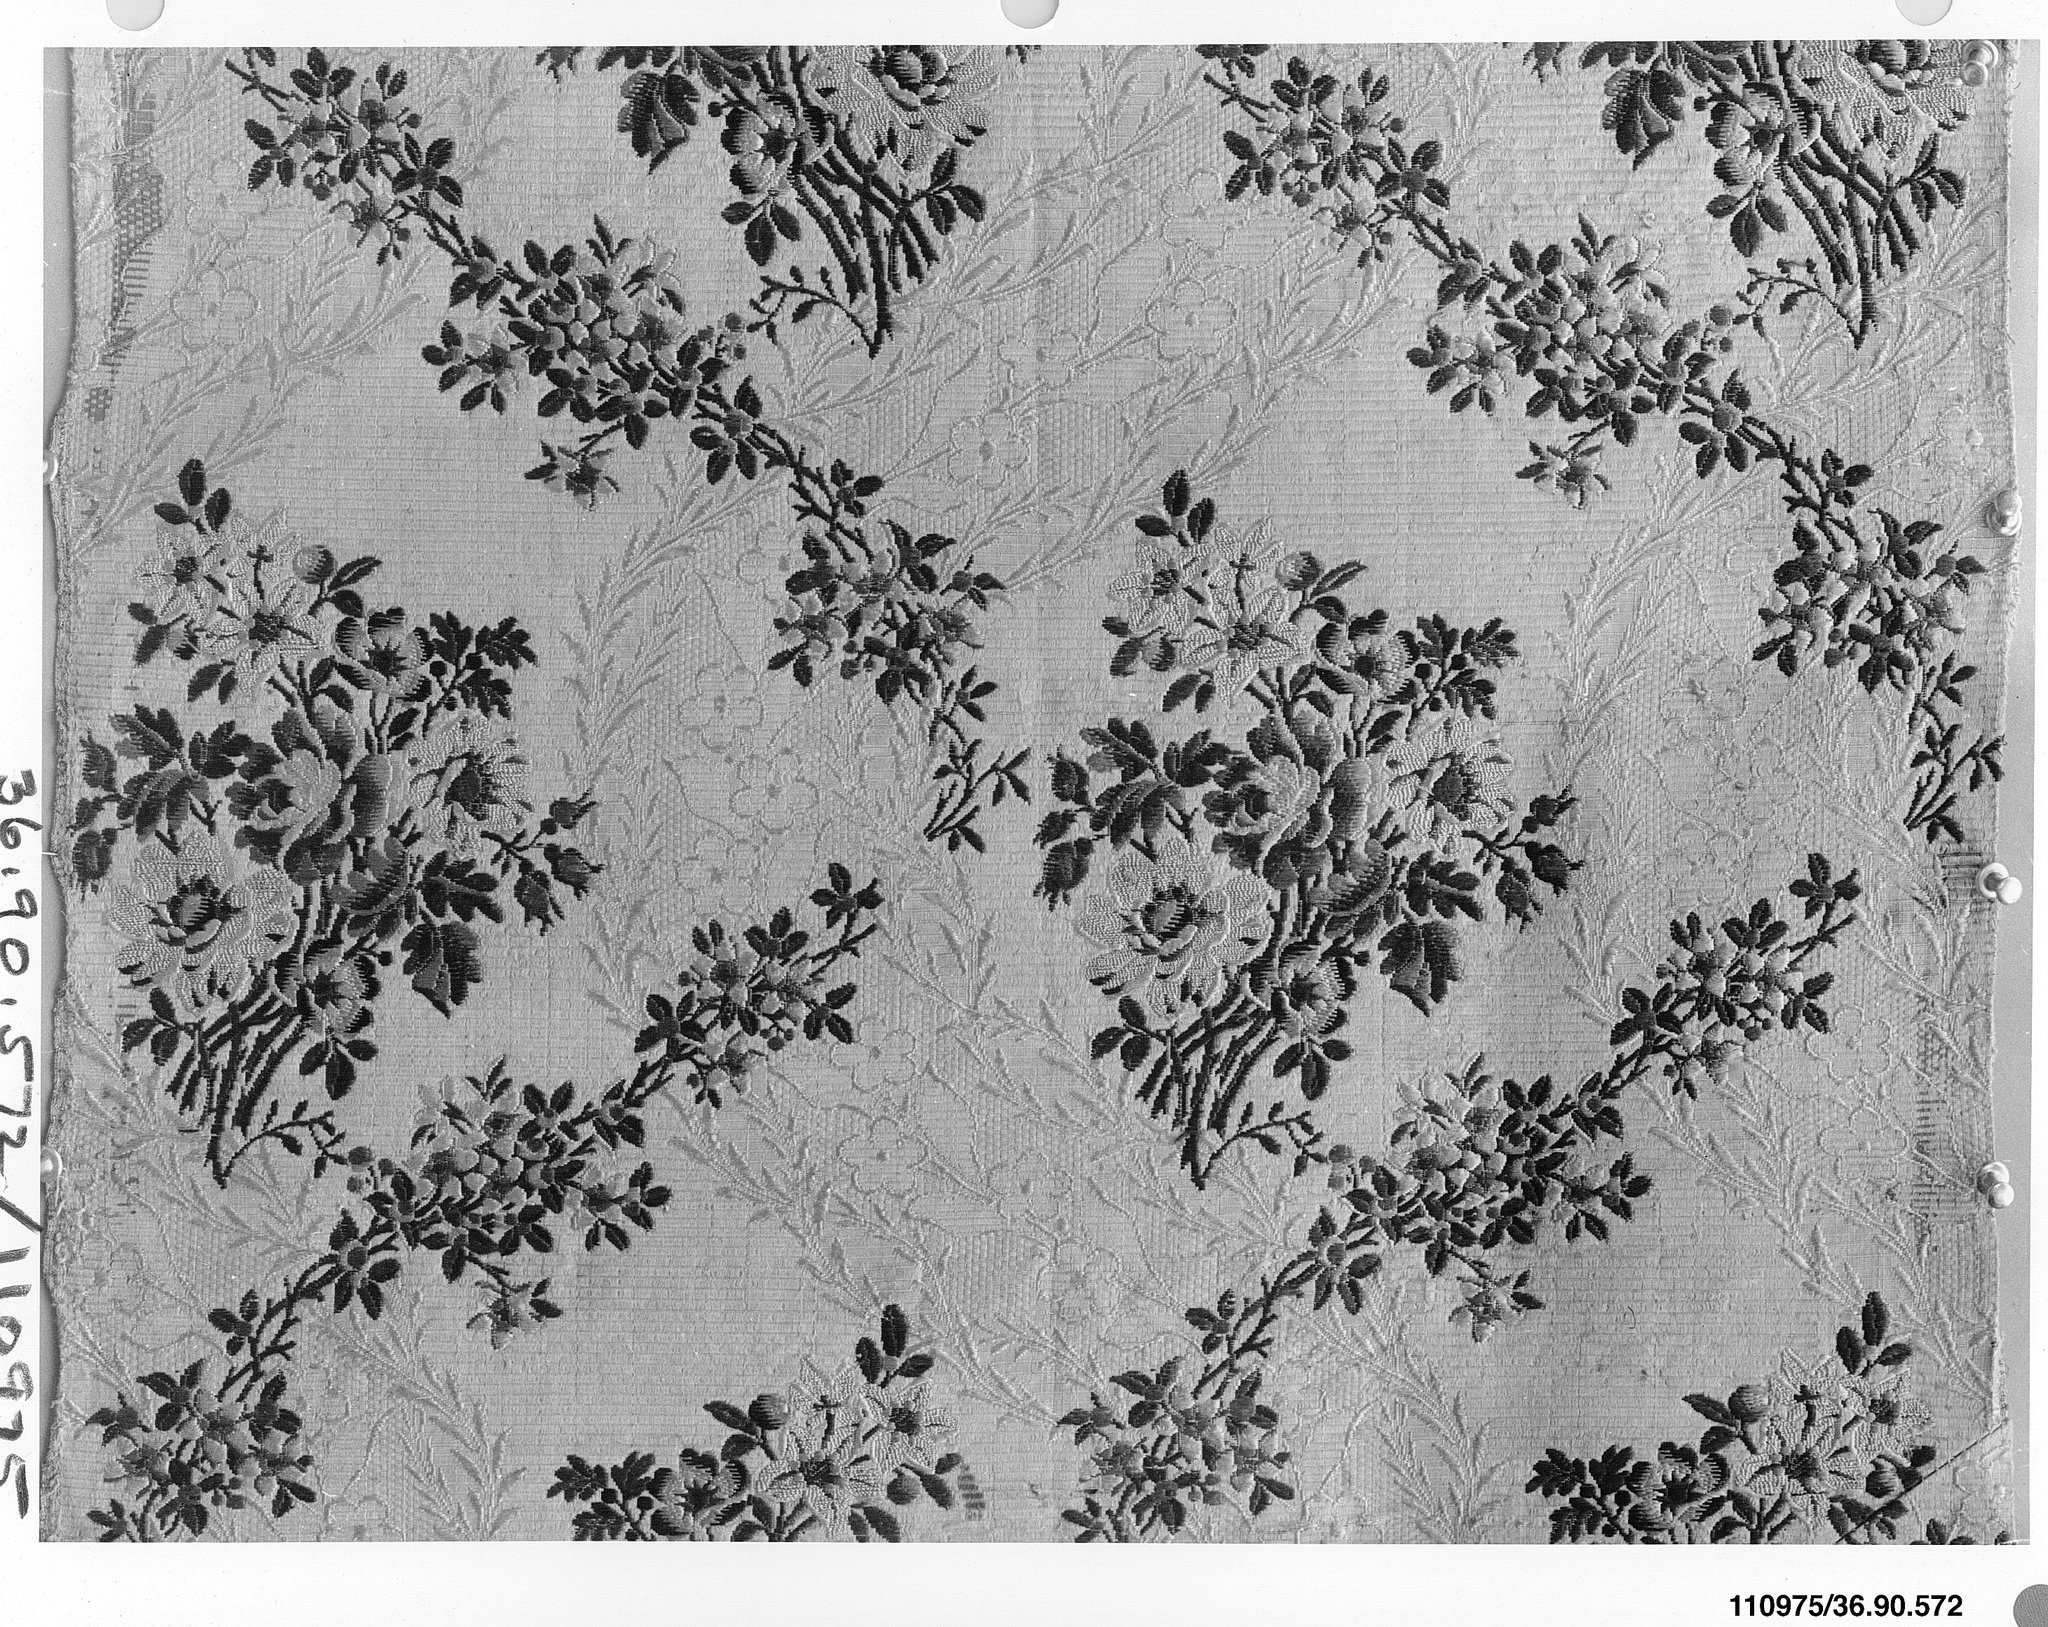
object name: piece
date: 1734-1766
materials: silk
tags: flowers,leaves